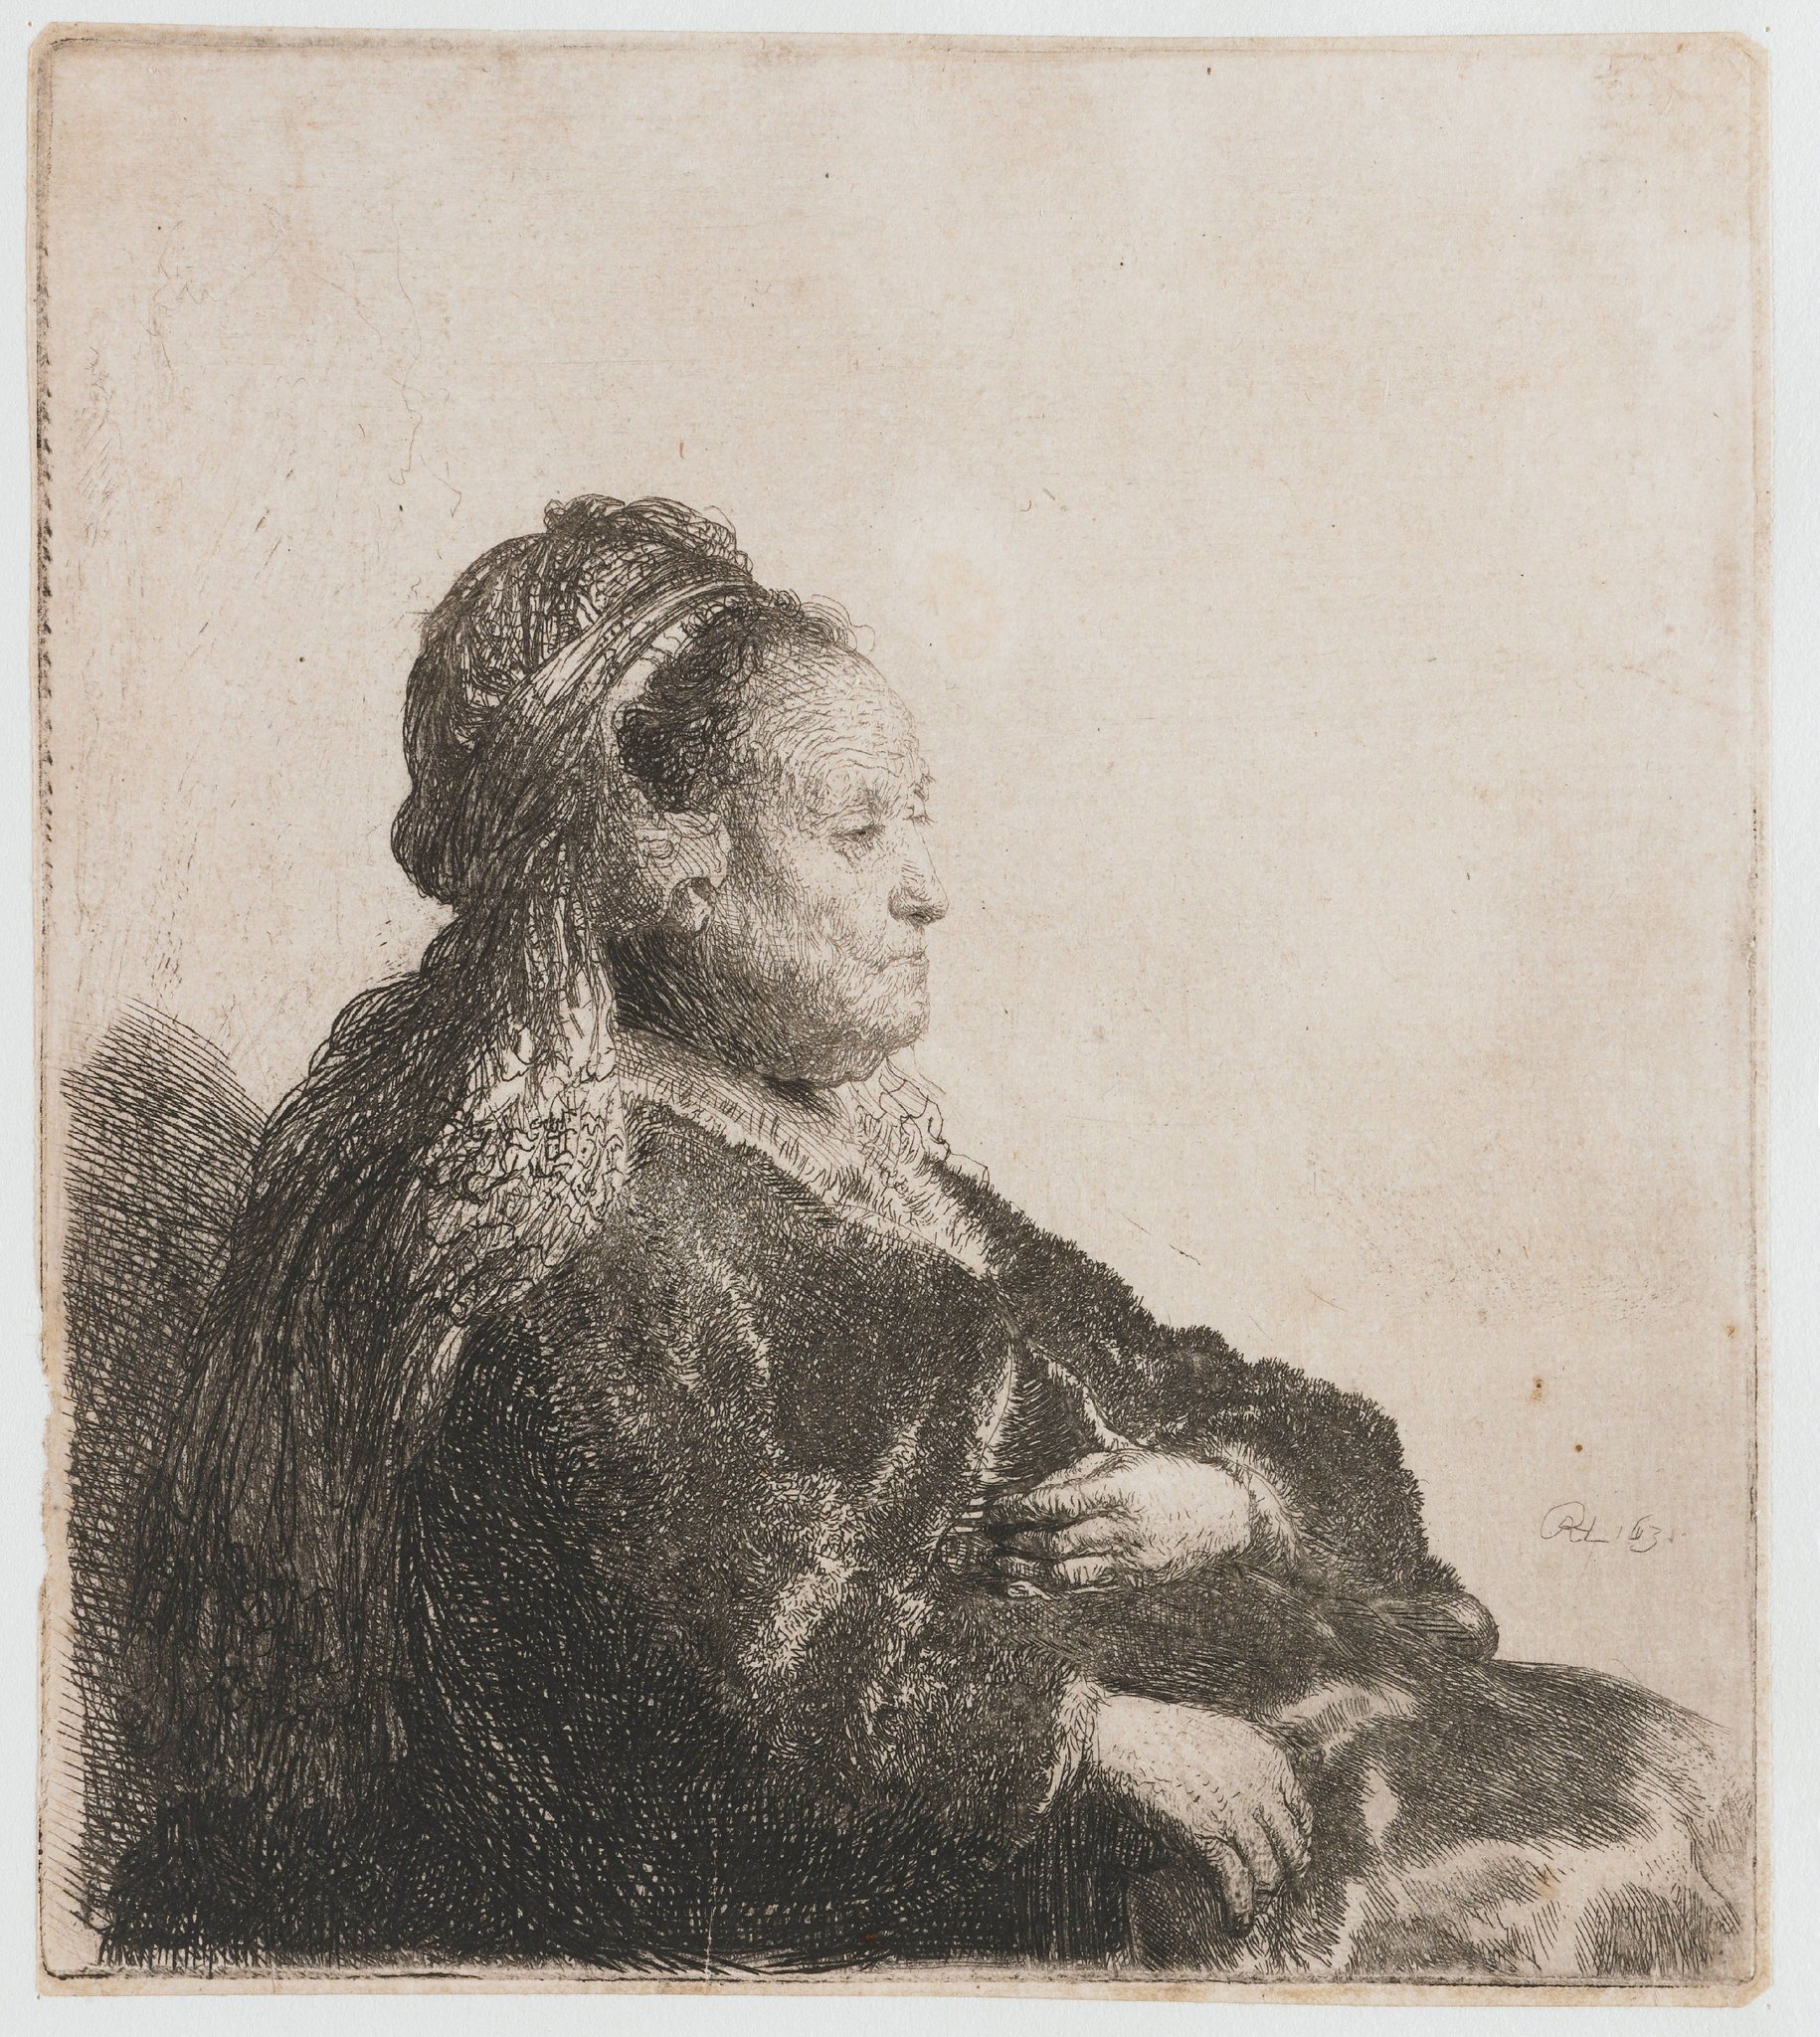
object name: print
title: Rembrandt’s Mother Seated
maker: rembrandt van rijn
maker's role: draughtsman, painter, print maker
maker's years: 1606-1669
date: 1631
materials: paper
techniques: etching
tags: neeltje willemsdr. zuytbrouck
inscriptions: monogram and date: ‘RHL 1631’, mark: Lugt 2228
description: Rembrandt’s mother most certainly modelled here, yet not for the usual facial studies, but rather for larger, tronie-like interpretations. At left, she sits like an ‘oude Persiaanse vrou’ (old Persian woman) in an imaginary, Oriental-looking headdress. At right, she wears a mid-16th-century shirt, so contemporaries would immediately have understood that she was garbed ‘op zijn antieks’ (à l’antique).